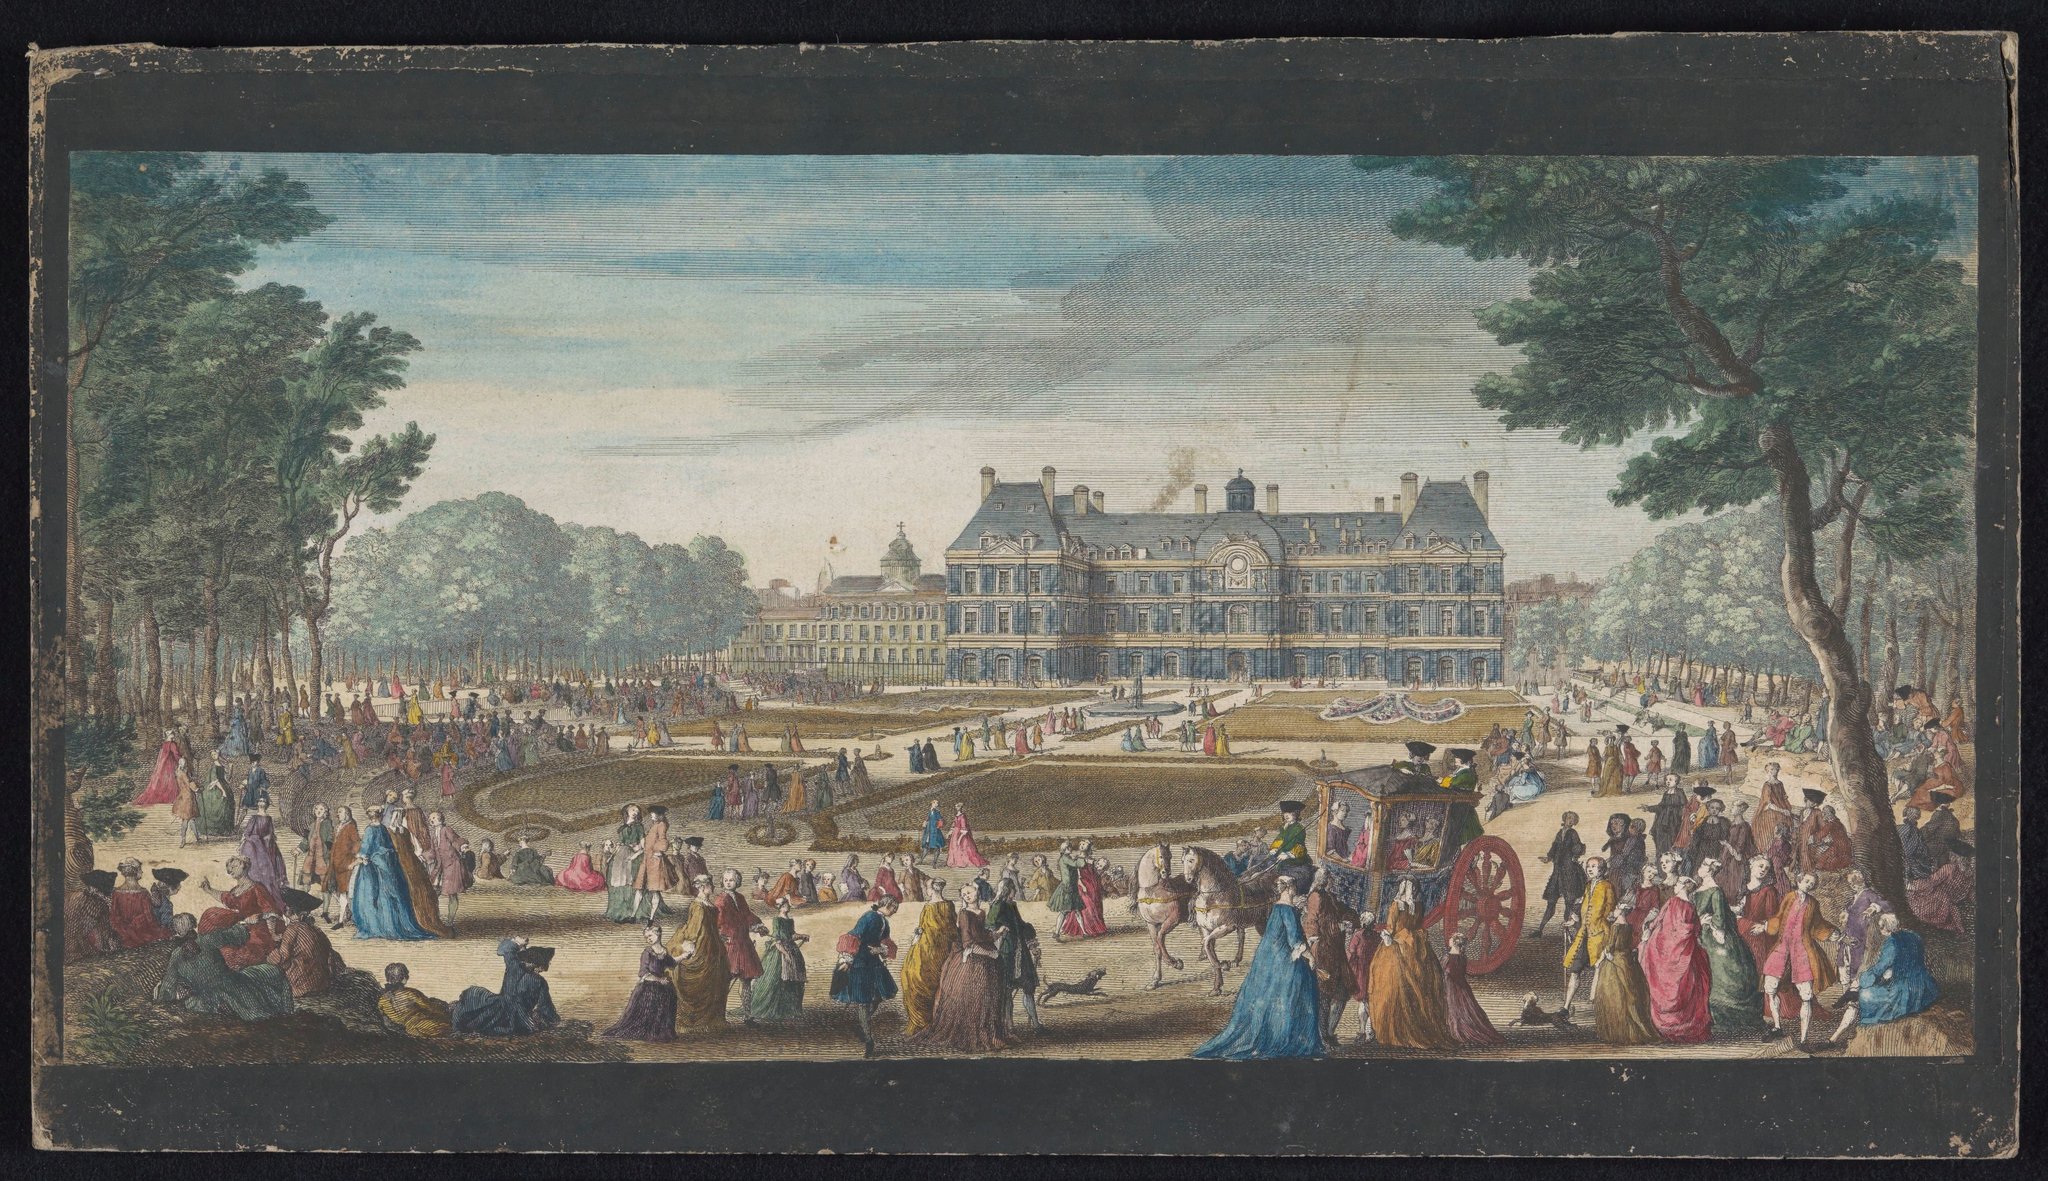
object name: opticaprent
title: Les promenades du Luxembourg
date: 1729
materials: cardboard, paper, watercolor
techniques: brush, etching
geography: paris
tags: garden, garden fountain, ornamental plants, palace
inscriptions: collector's mark: Lugt 2233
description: In de tuin wandelen en zitten groepen figuren.